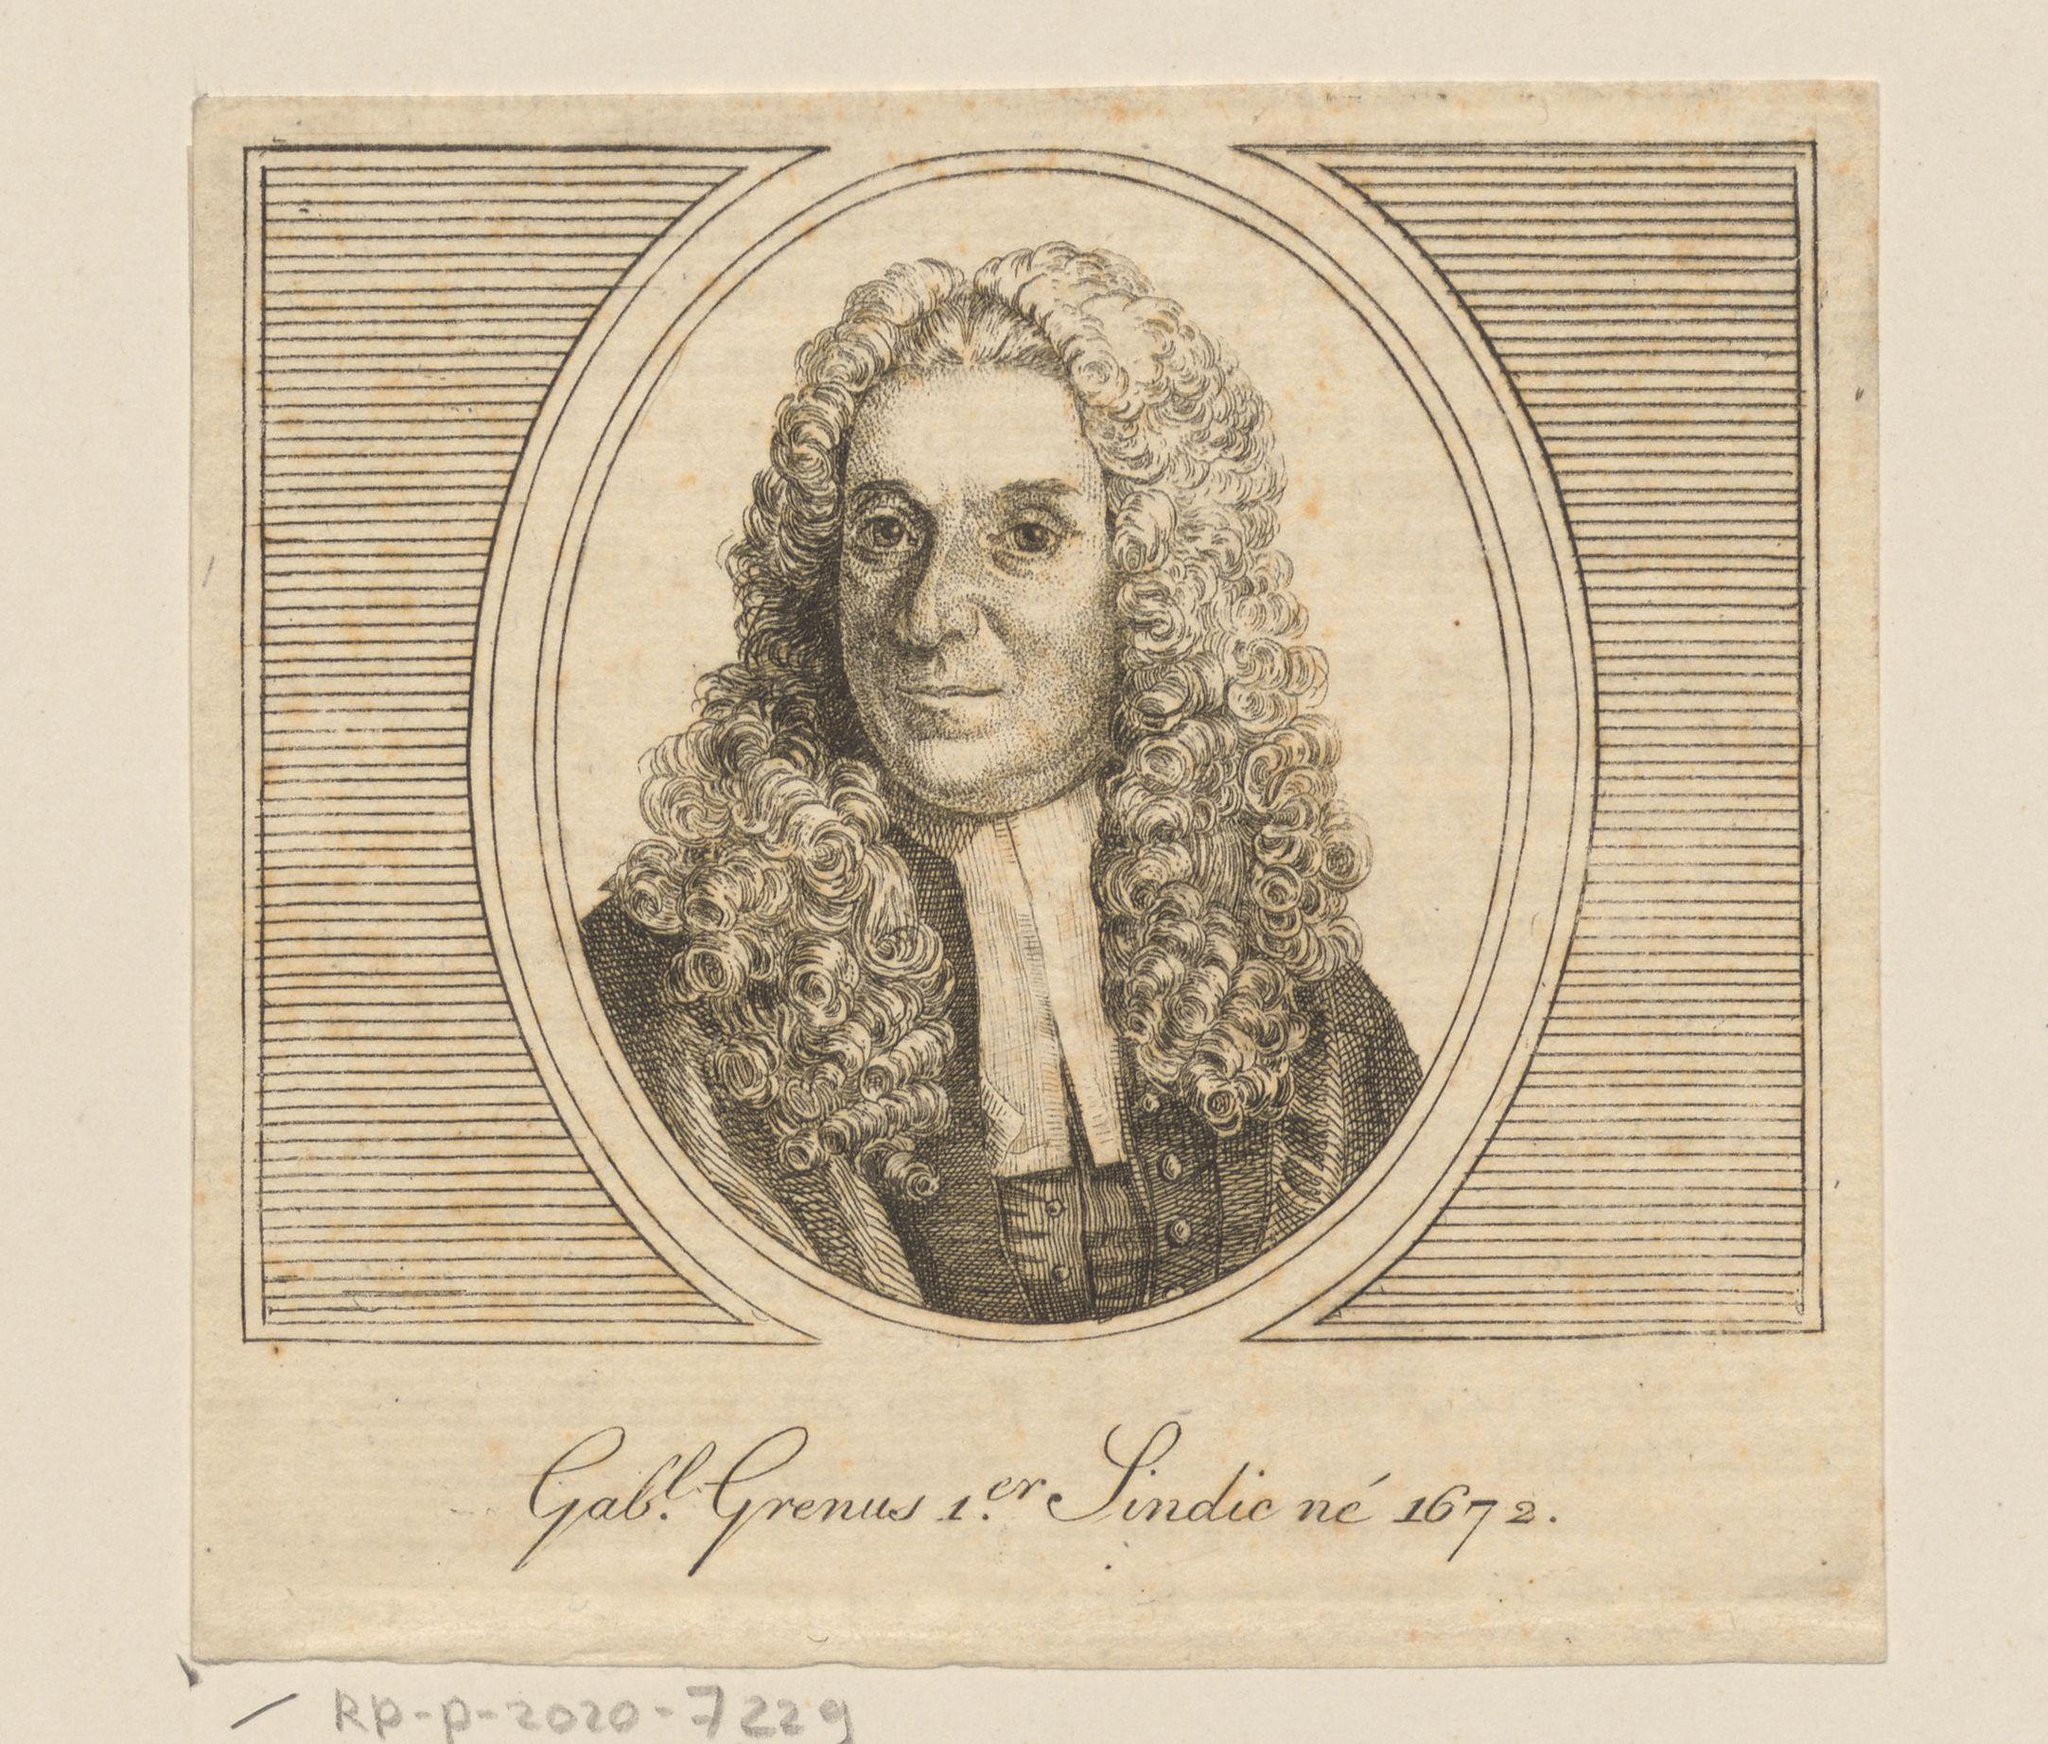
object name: print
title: Portret van Gabriel de Grenus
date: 1815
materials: paper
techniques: engraving, letterpress printing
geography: geneva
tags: historical persons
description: Prent uit: Grenus-Saladin, François Théodore Louis. Fragmens biographiques et historiques, extraits des registres du Conseil d'Etat de la République de Genève (...). Genève: Gaspard Joël Magnet en Abraham Cherbuliez, 1815, p. 253.